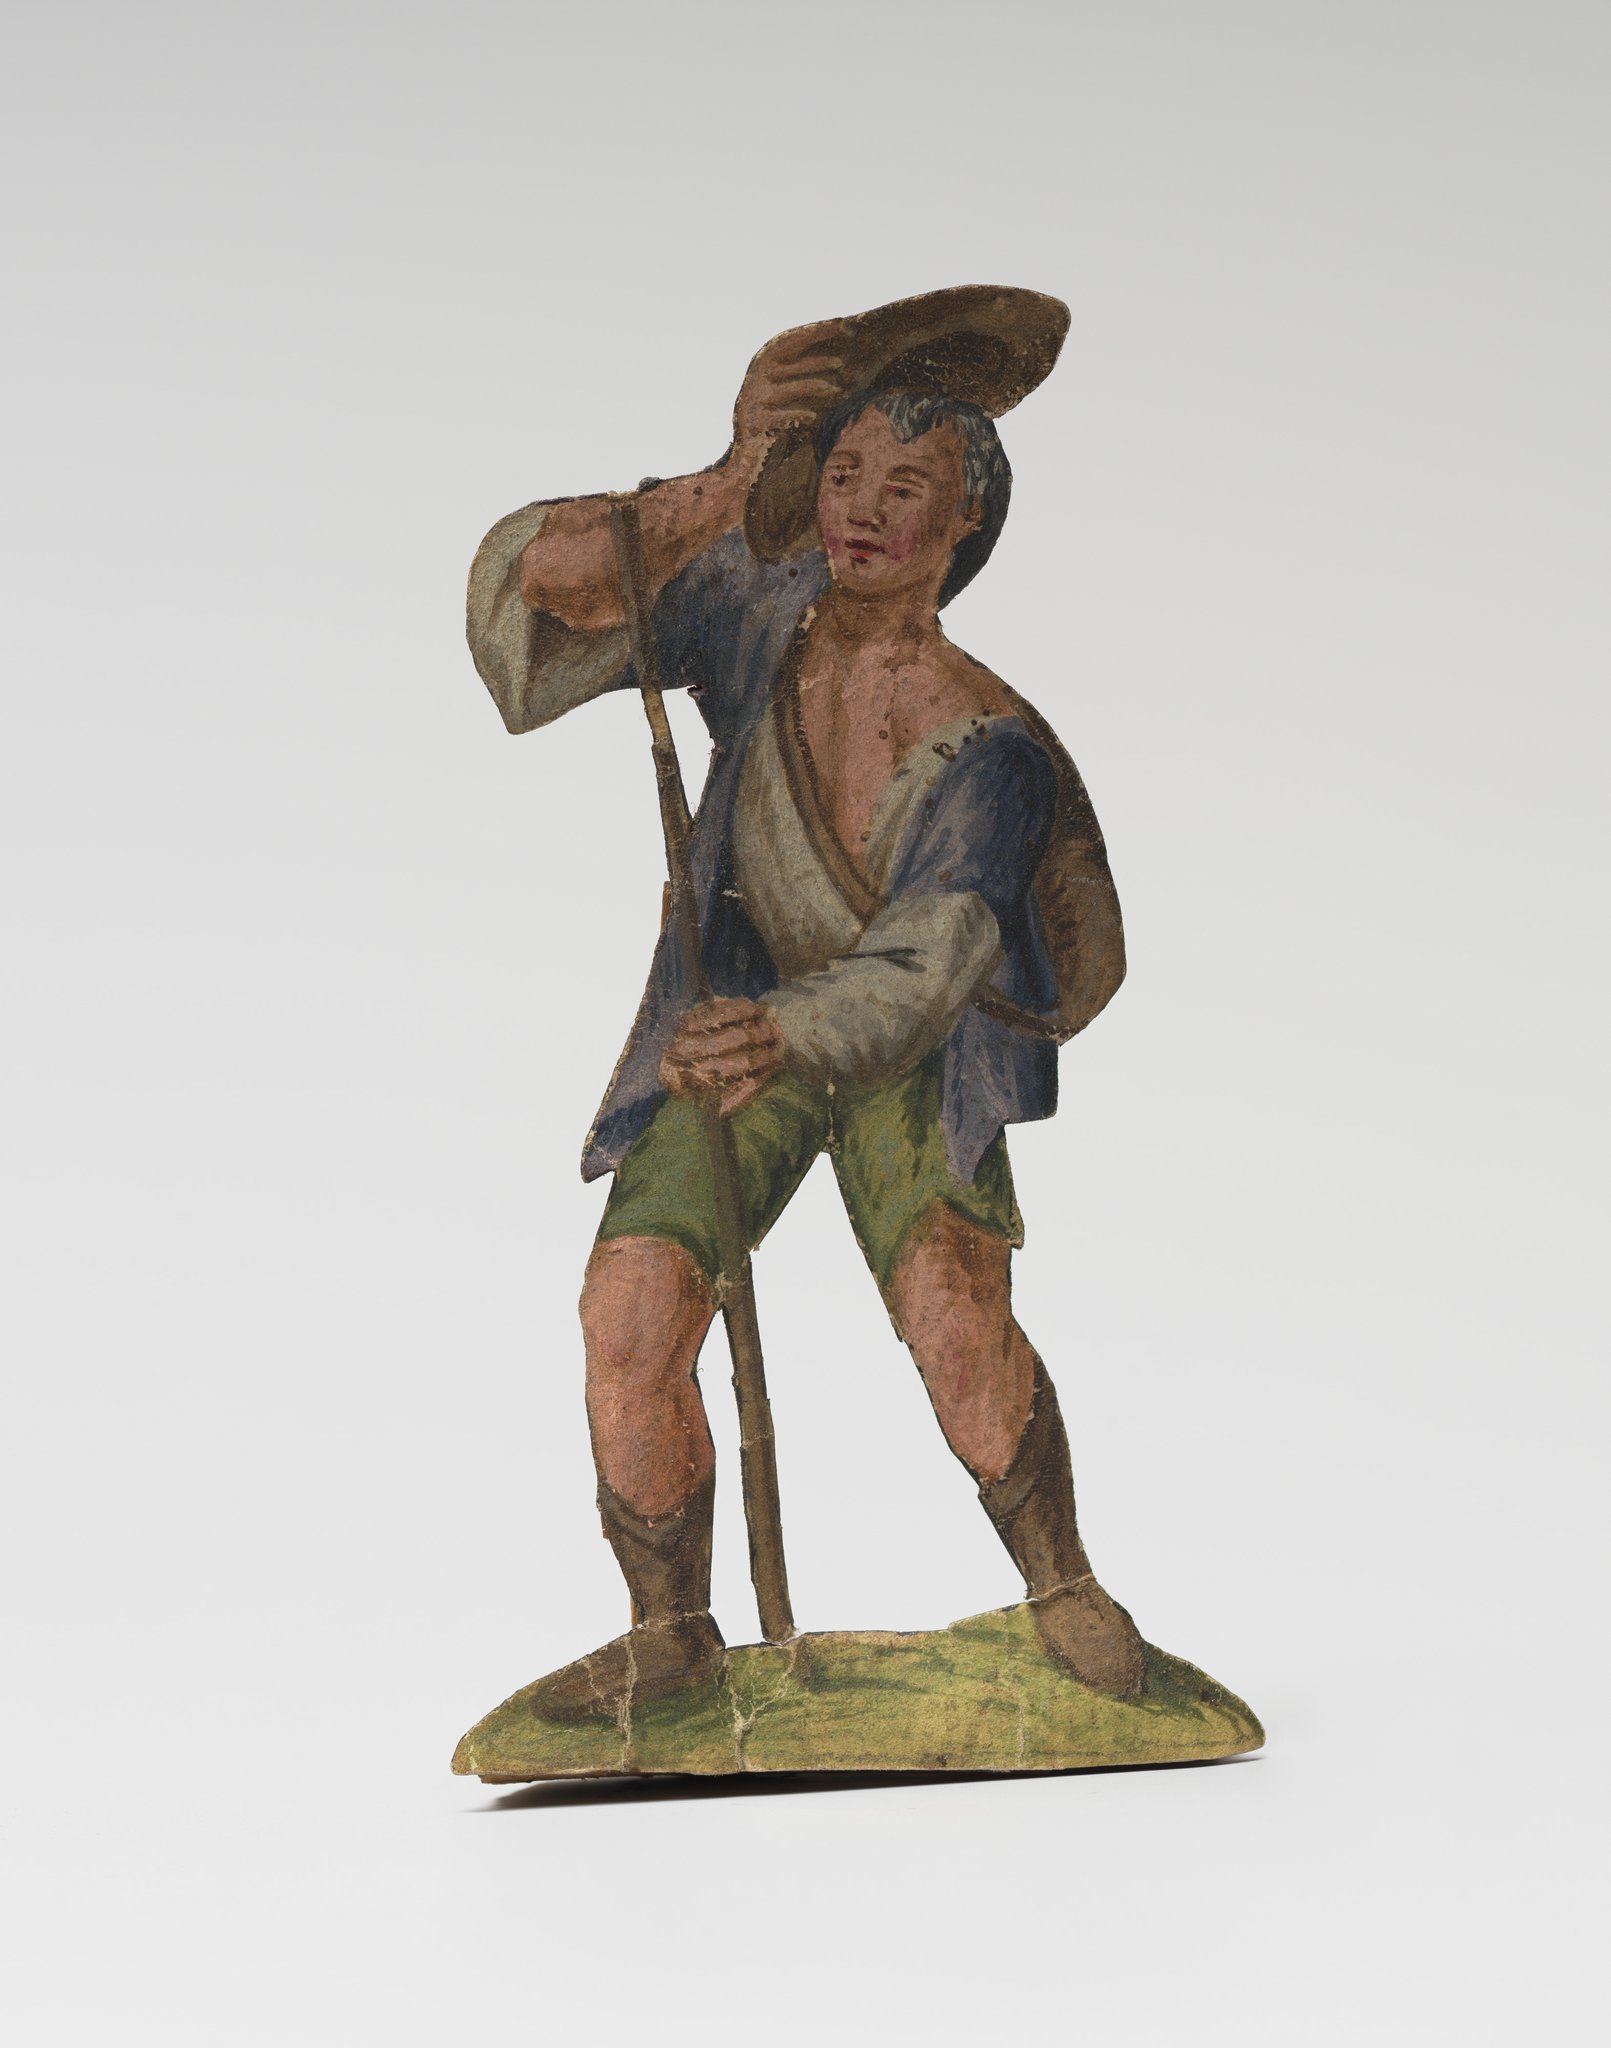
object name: figure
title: Two Shepherds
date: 1701-1800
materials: gouache, paper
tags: men,shepherds